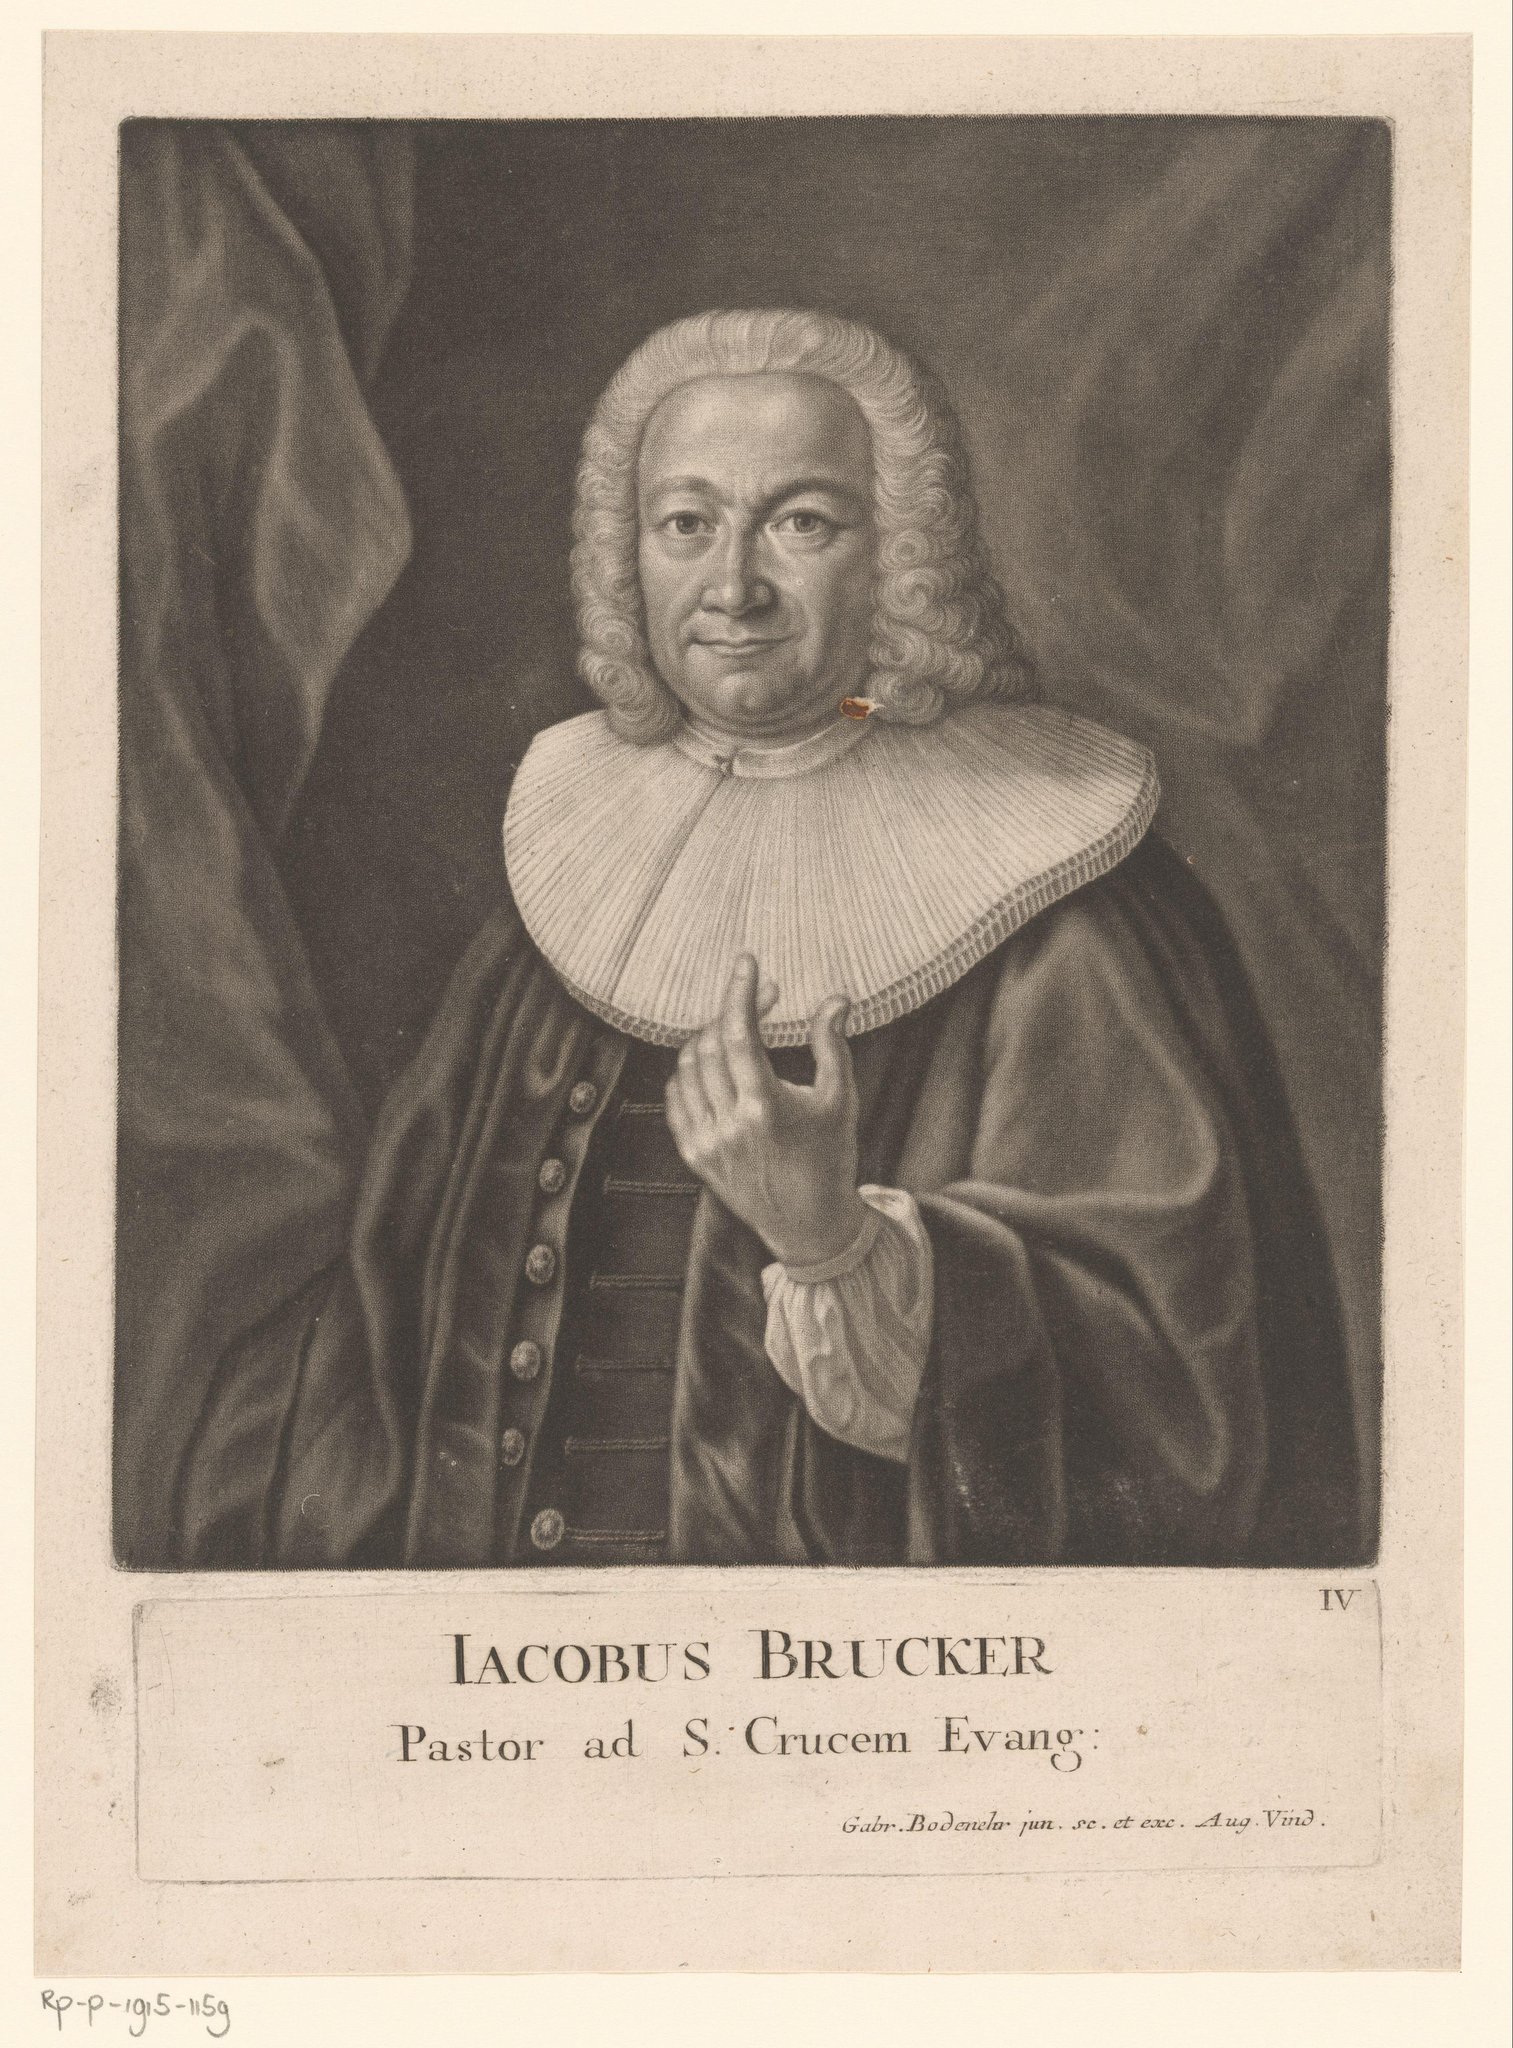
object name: print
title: Portret van Jakob Brucker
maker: gabriel bodenehr (ii)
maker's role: print maker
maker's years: 1705-1792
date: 1715-1792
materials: paper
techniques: mezzotint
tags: augsburg, jacob brucker, theologian, historical persons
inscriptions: collector's mark: Lugt 2228